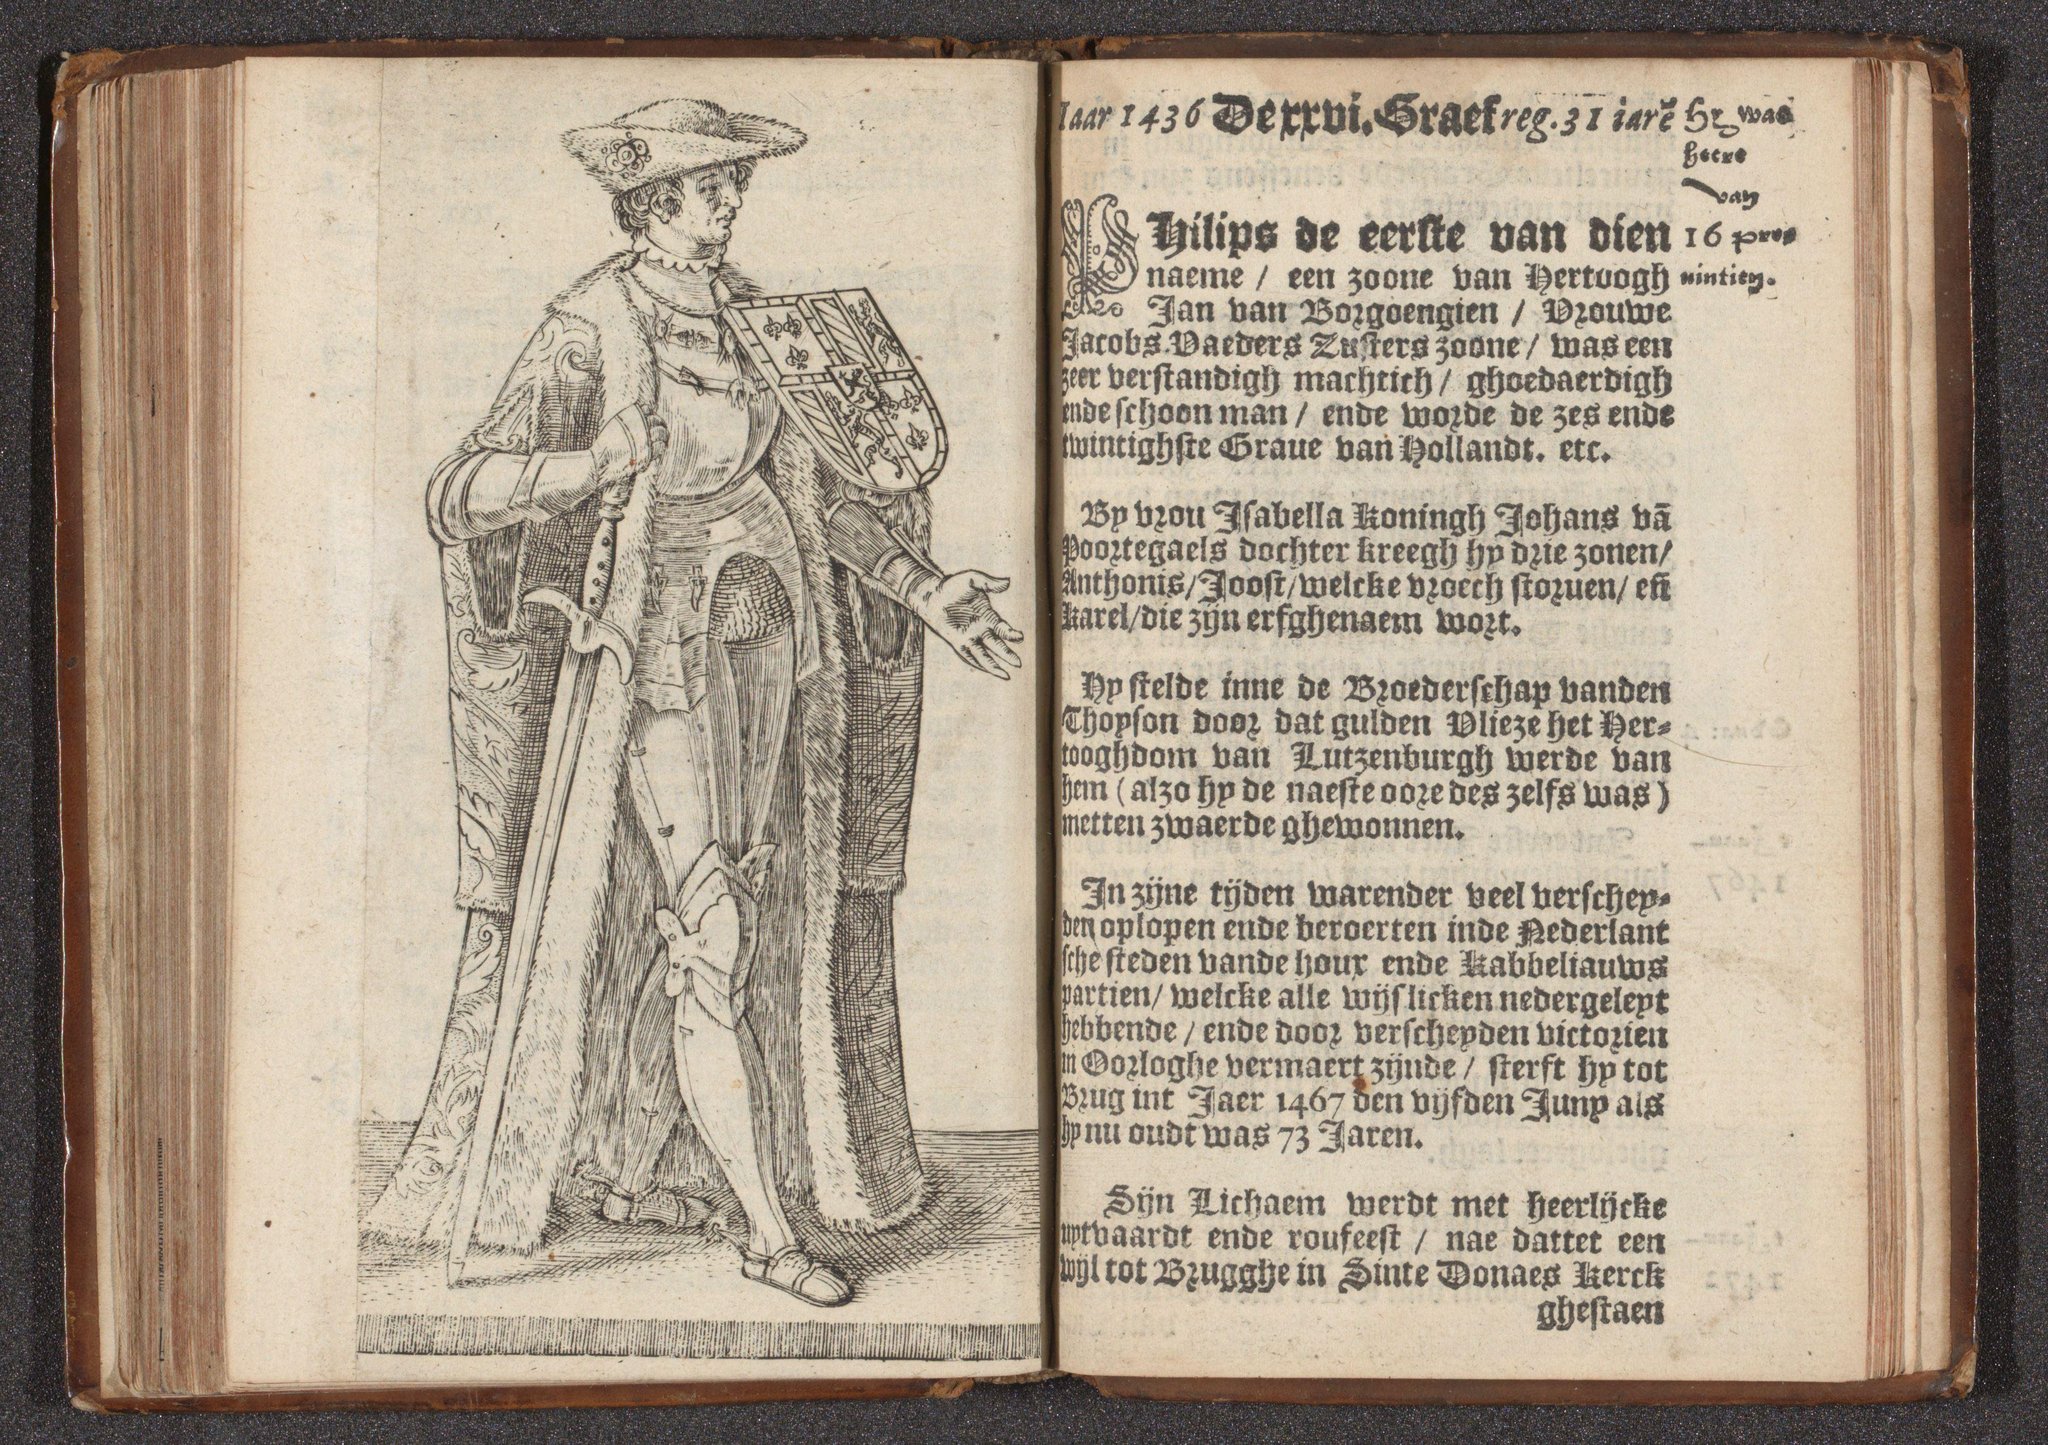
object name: book illustration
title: Graven en gravinnen van Holland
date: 1586-1587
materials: paper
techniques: engraving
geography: haarlem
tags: bruges, philip iii the good, historical persons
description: Filips de Goede, ten voeten uit en naar rechts gekeerd. Met wapenschild en zwaard. De prent maakt deel uit van een boek met beschrijvingen en voorstellingen van de graven van Holland, Zeeland en Friesland.